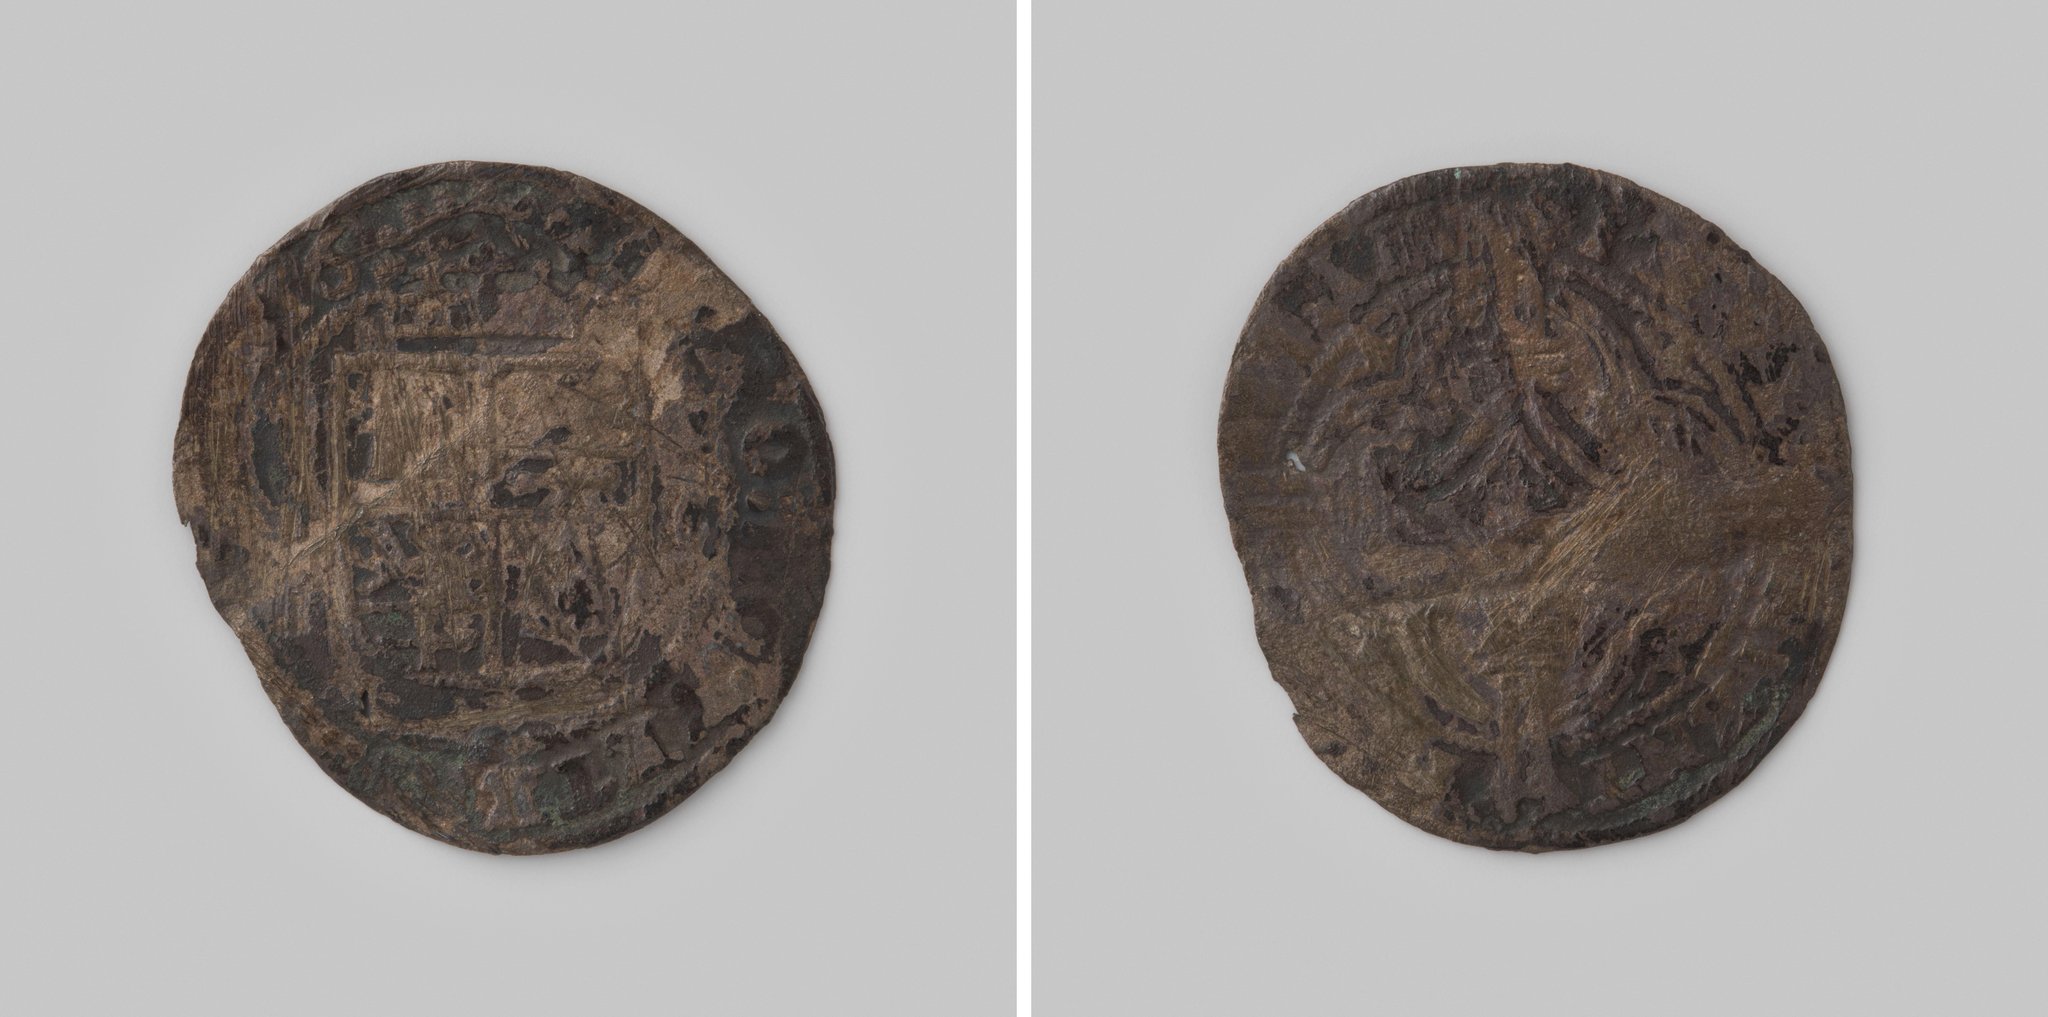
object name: coin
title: Zutphen, stuiver, 1605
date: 1605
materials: silver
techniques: striking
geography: zutphen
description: Zilveren munt. Voorzijde: tussen waarde-aanduiding gekroond vierdveldig wapenschild. Jaartal rondom kroon. Keerzijde: op een vierpas lang dubbellijning gevoet kruis, in het hart kruisje.